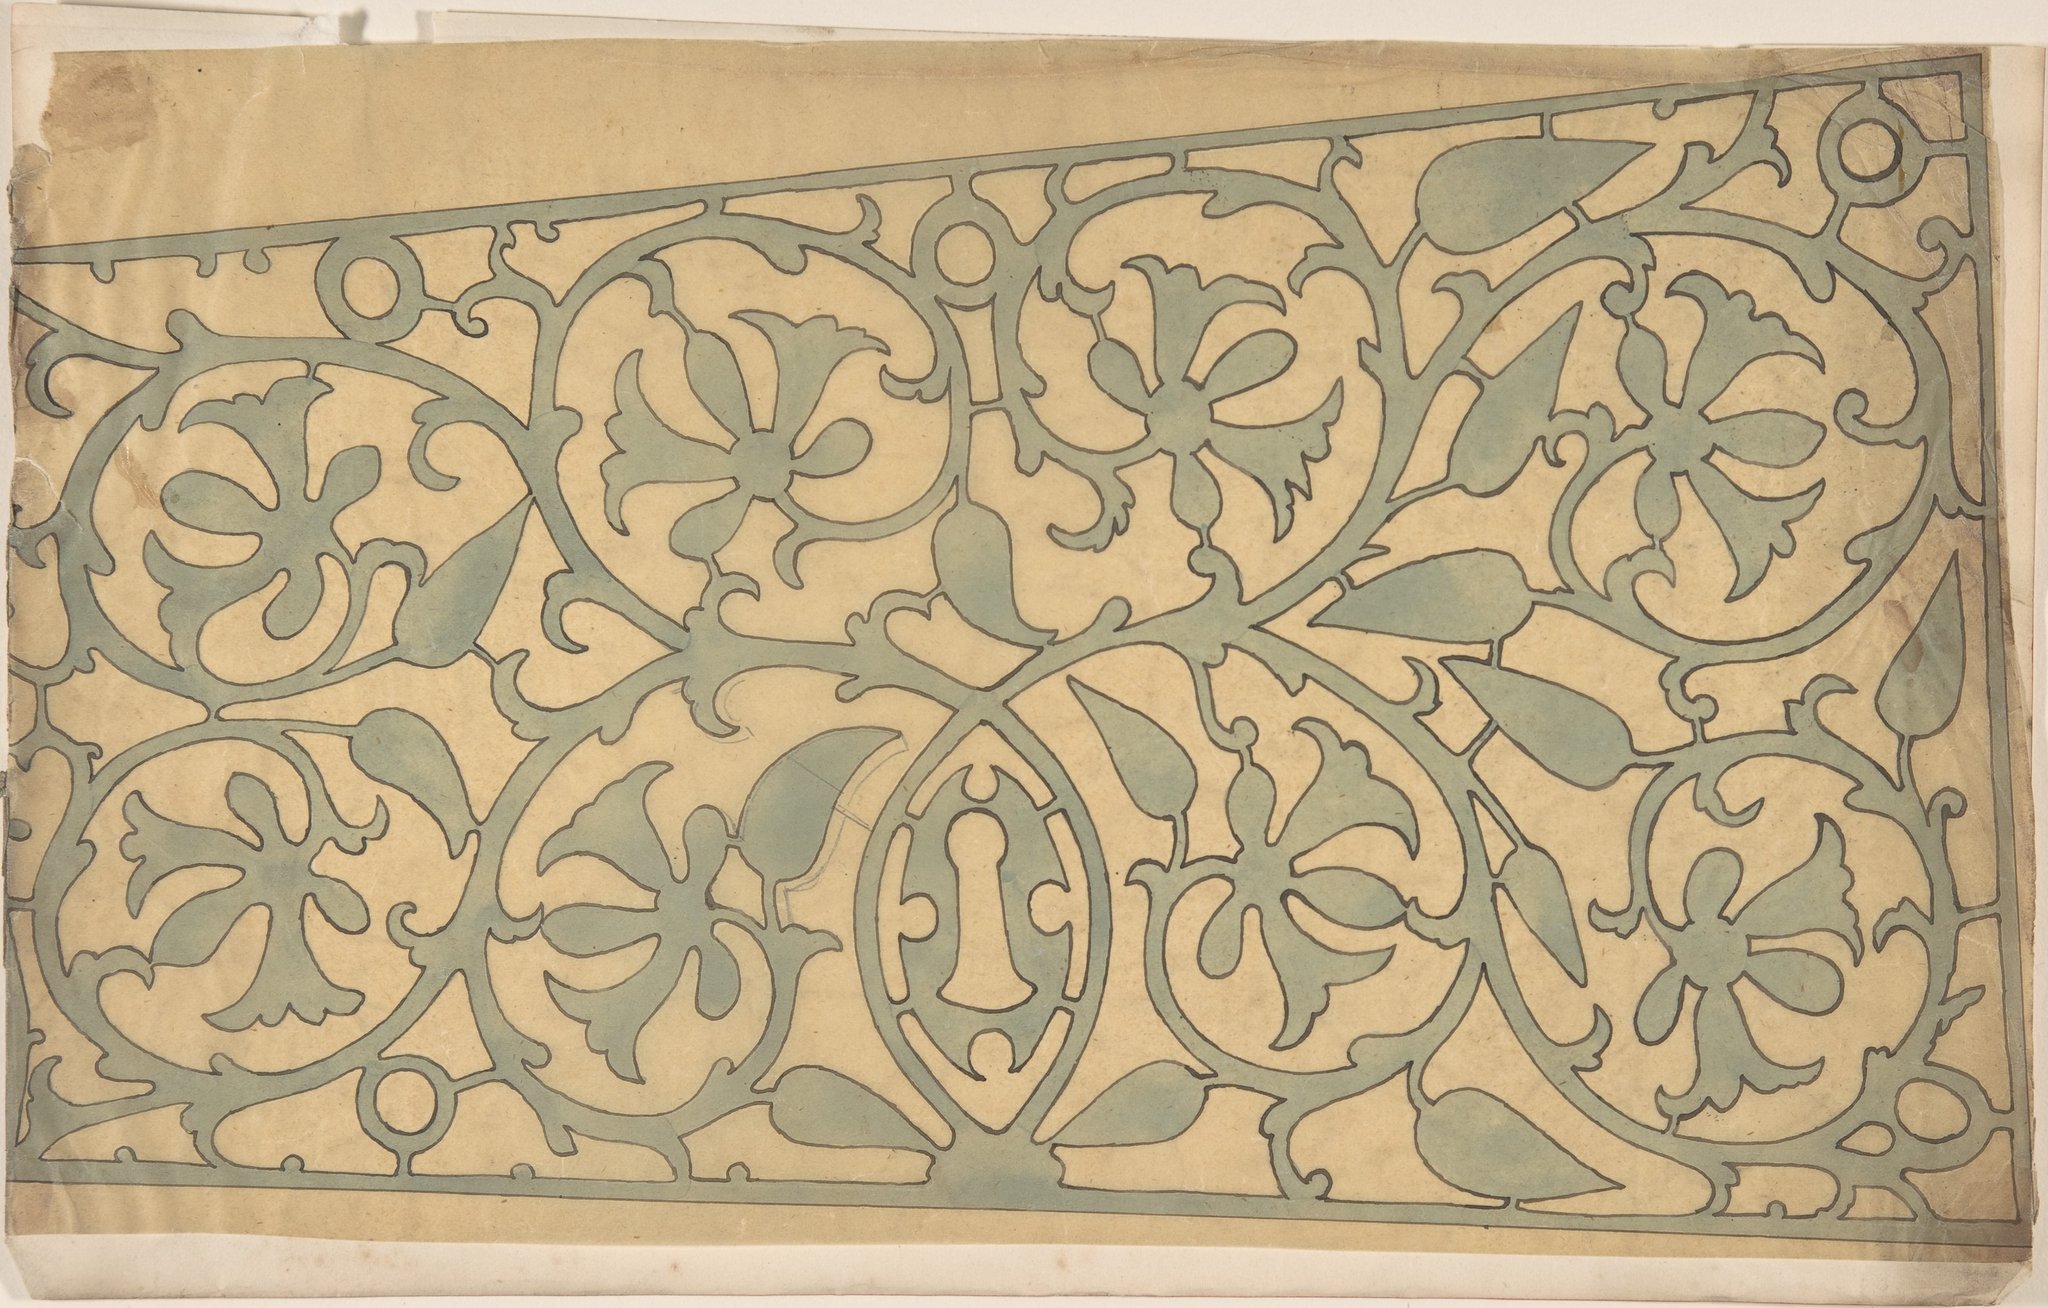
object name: drawing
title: Panel of Ornament, possibly Metalwork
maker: anonymous, british, 19th century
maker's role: artist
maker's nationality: british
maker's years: 1800-1900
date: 1851-1900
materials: ink, watercolor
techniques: pen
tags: ornament